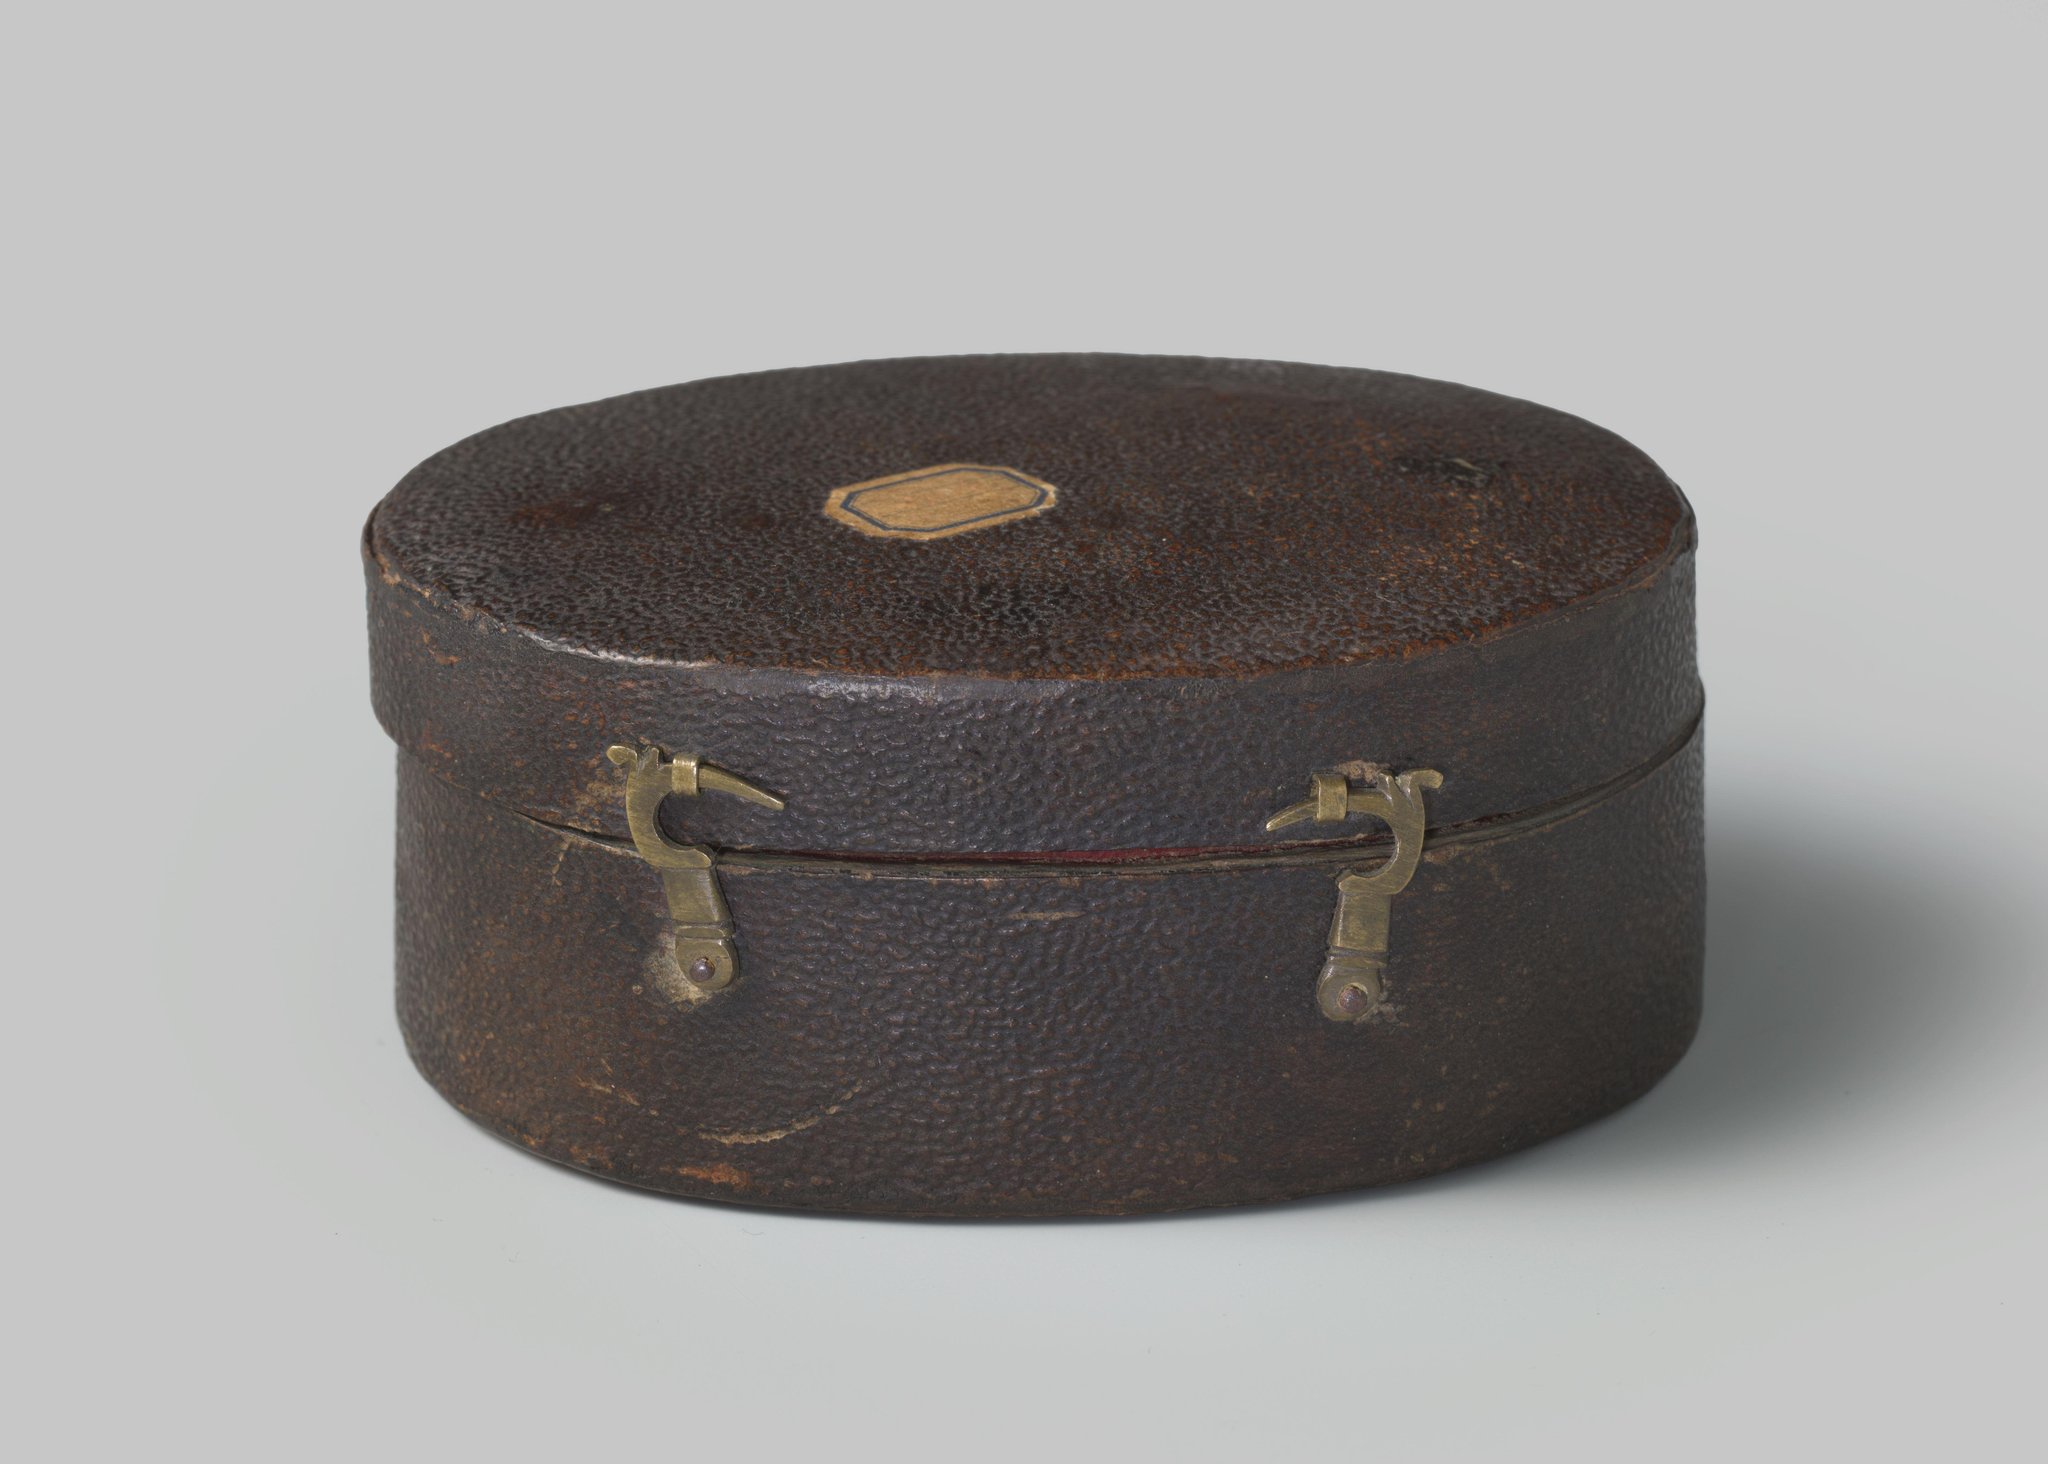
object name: case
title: Foedraal voor snuifdoos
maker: Anonymous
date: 1850-1950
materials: skin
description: Ovalen houten doosje met zwart robbenvel bekleed. Van binnen bekleed met rood fluweel. Aan de voorzijde twee sluithaakjes.